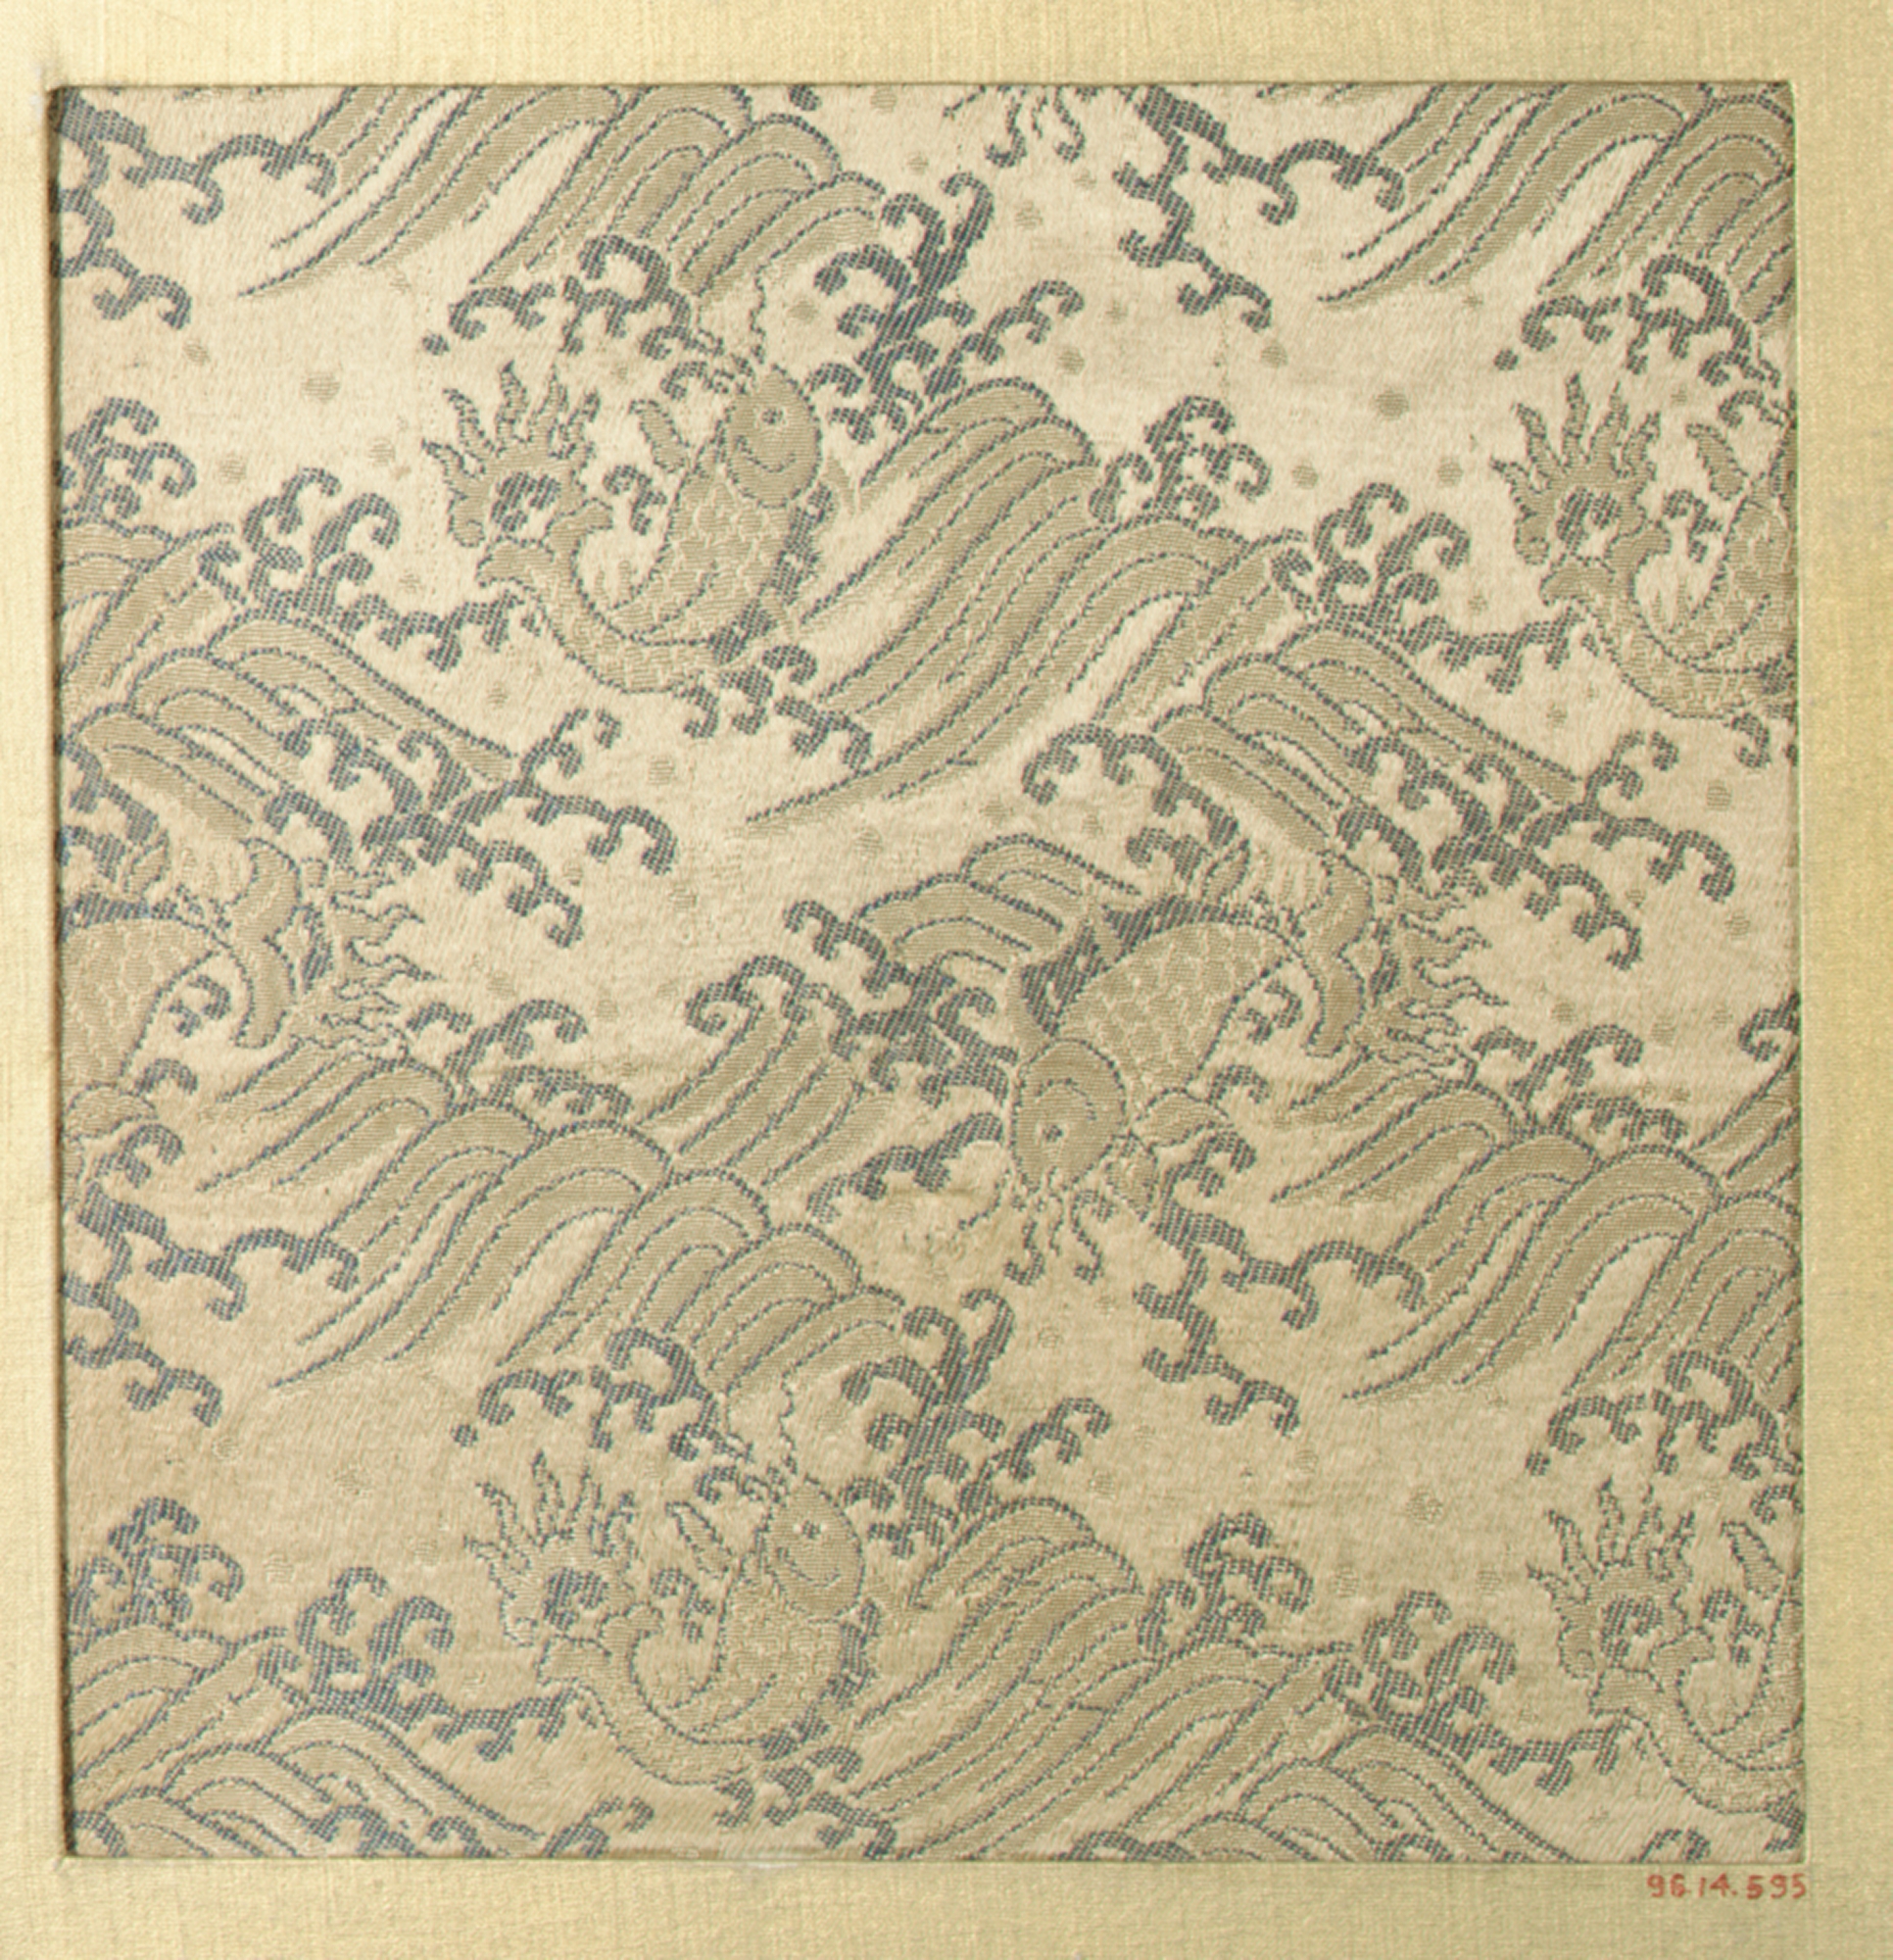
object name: piece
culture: japanese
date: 1701-1900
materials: silk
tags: fish,waves